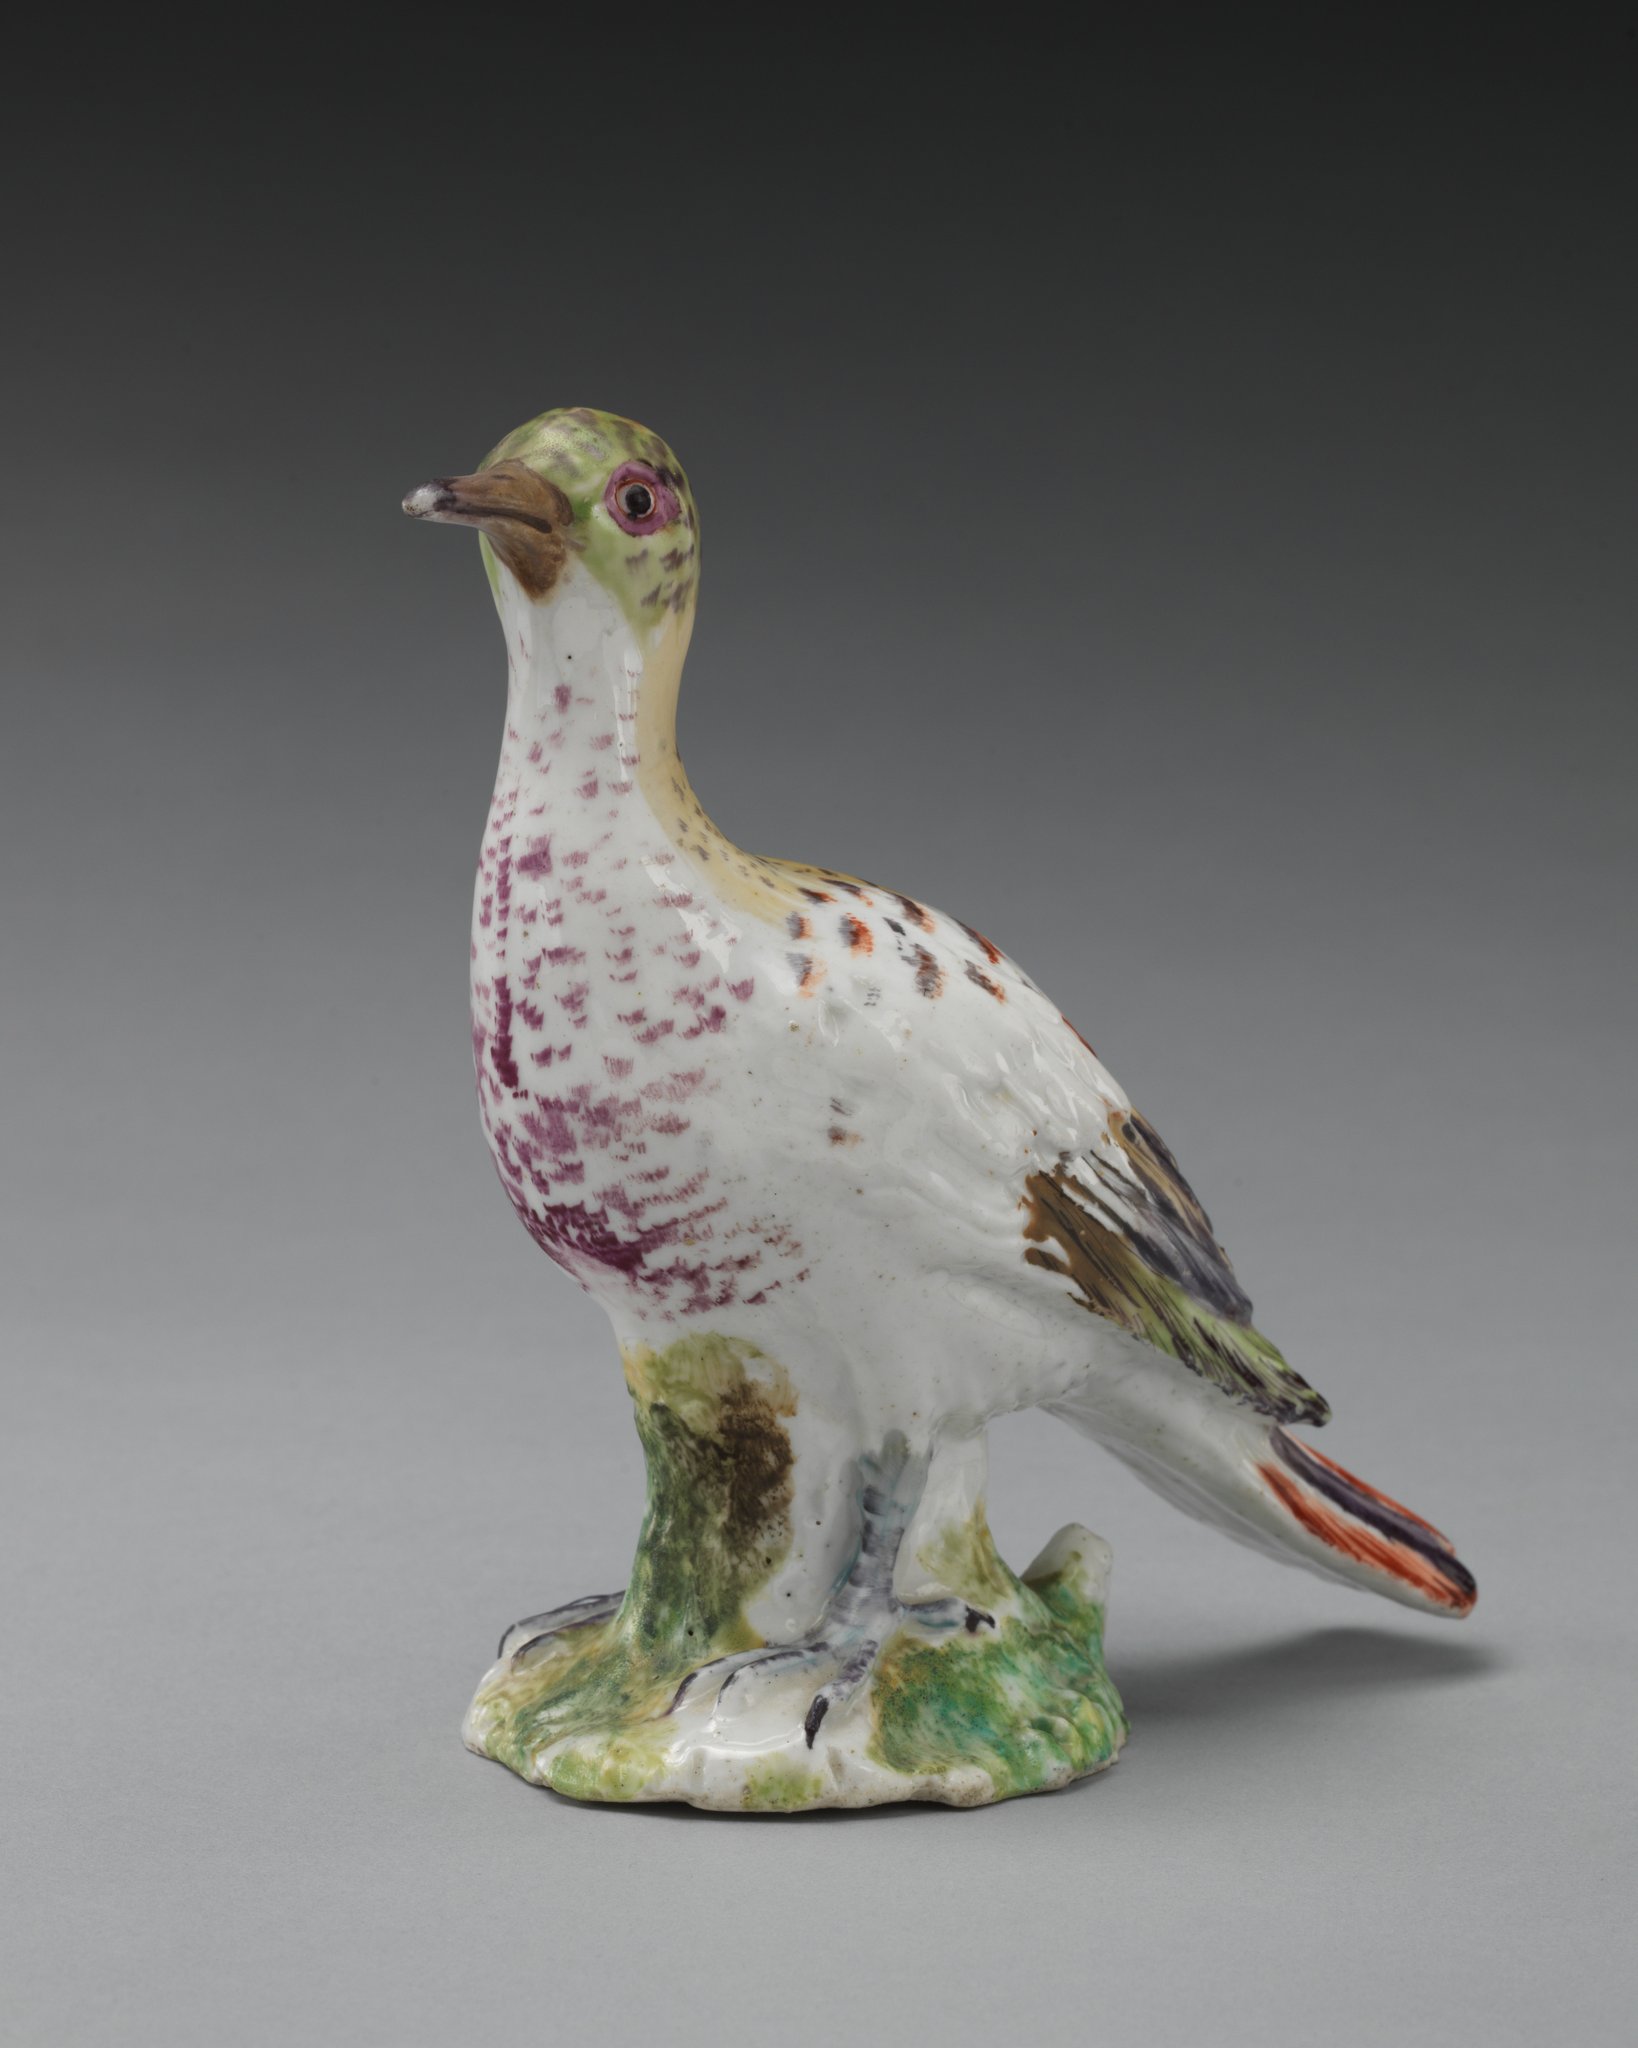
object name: figure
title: Dove (one of a pair)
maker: chelsea porcelain manufactory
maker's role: factory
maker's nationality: british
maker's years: 1744-1784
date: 1750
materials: soft paste porcelain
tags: doves